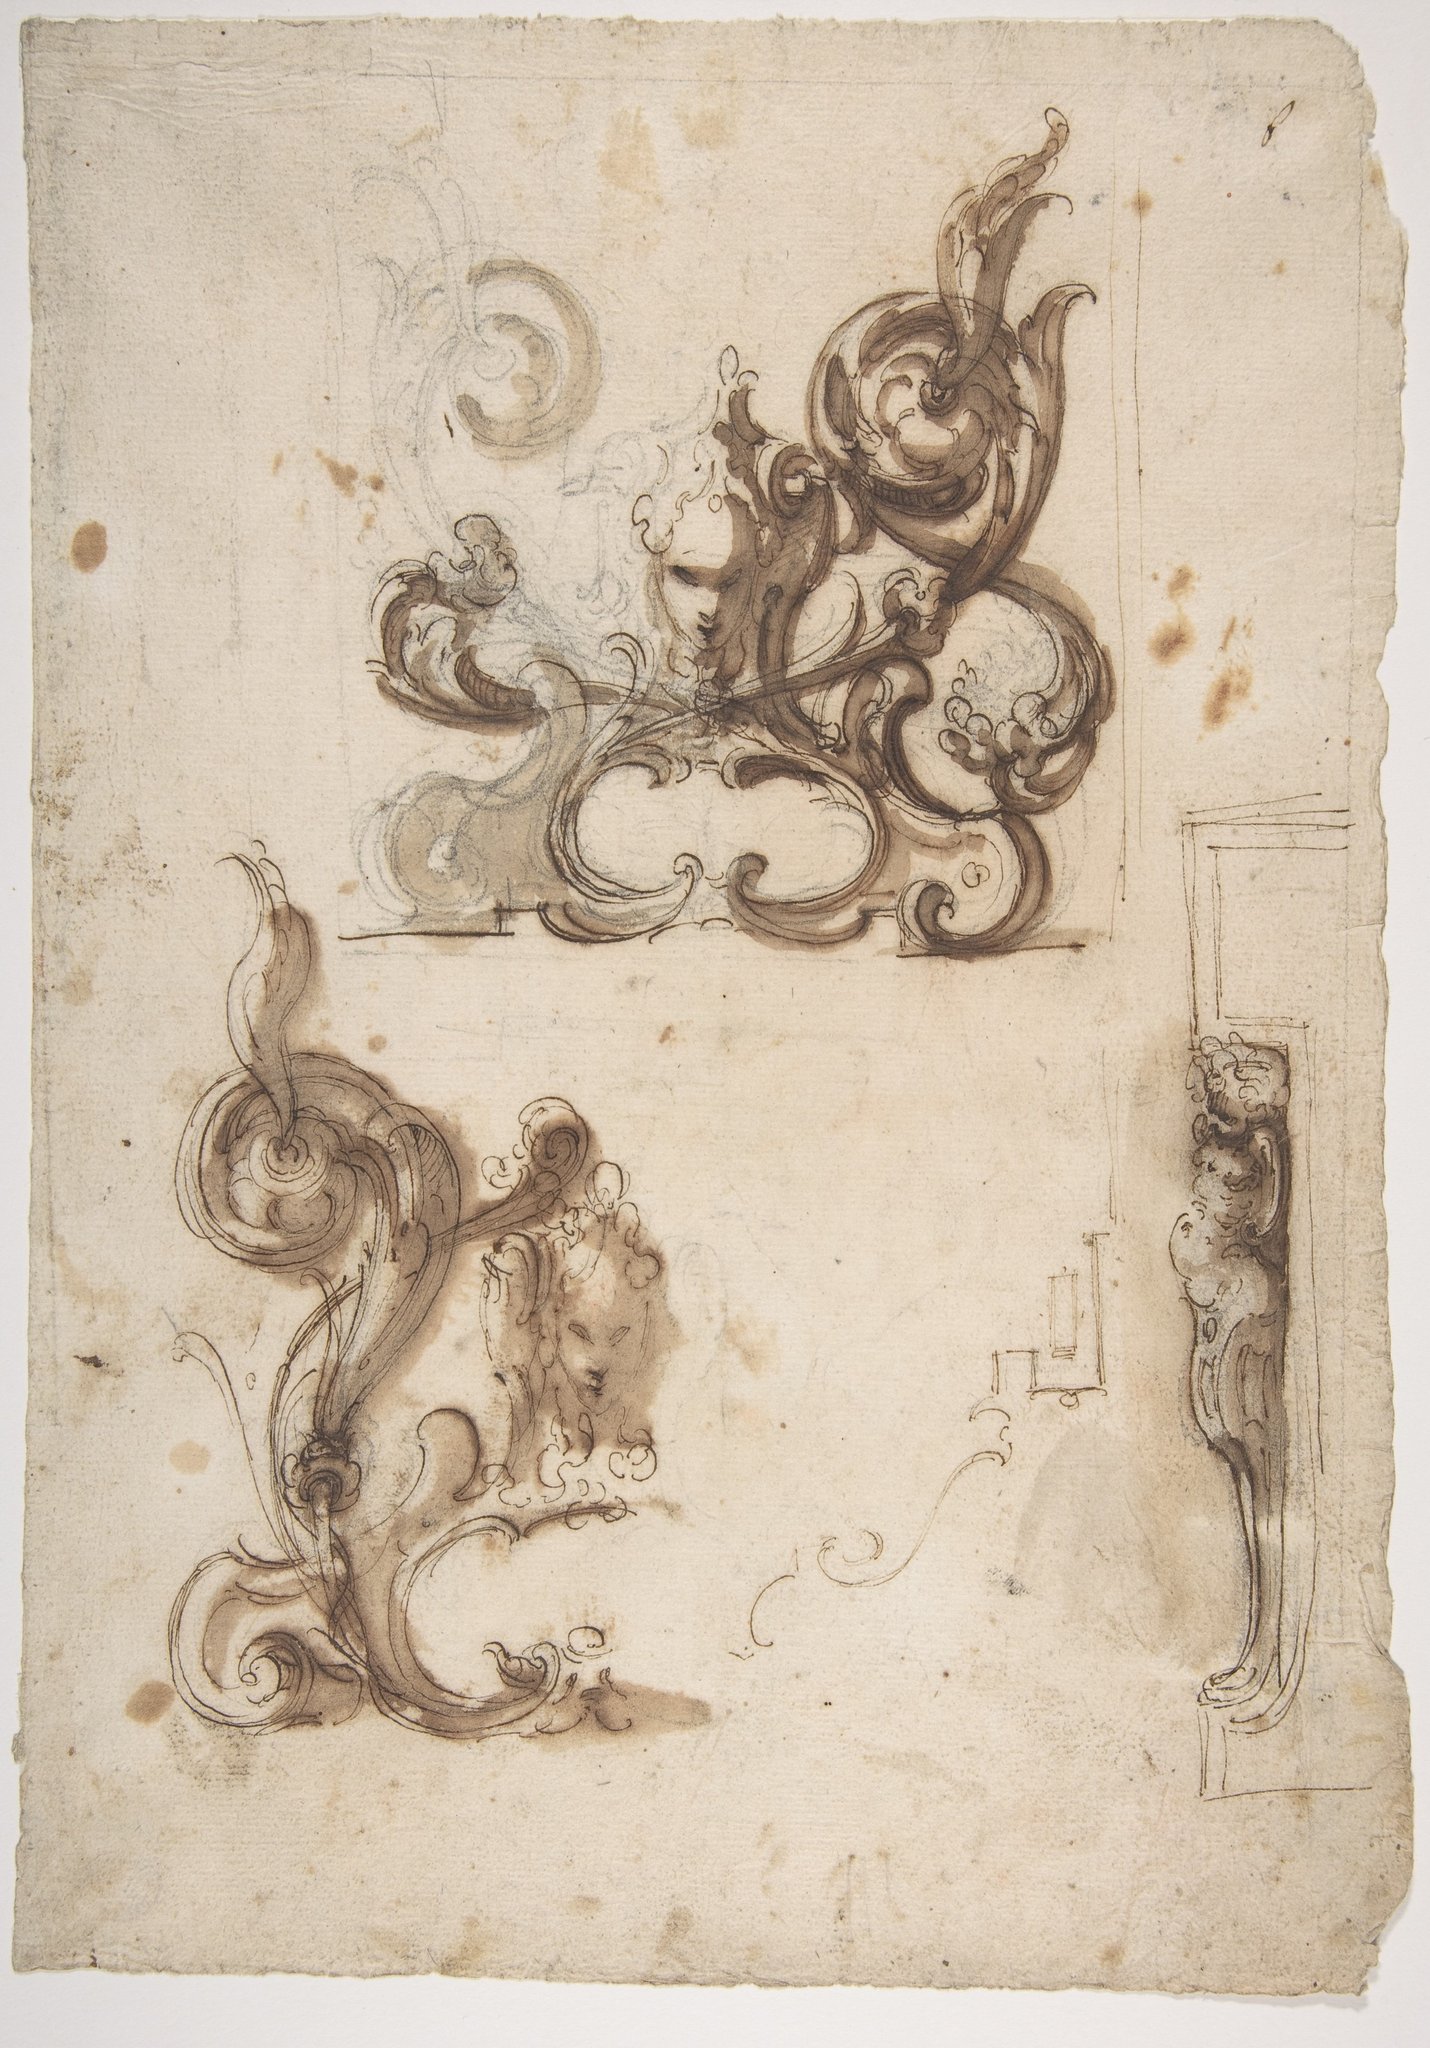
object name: drawing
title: Designs for Ornamental Motifs and for a Herm Supporting a Chimney Piece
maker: guglielmo caccia, called il moncalvo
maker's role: artist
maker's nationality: italian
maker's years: 1568-1625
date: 1568-1625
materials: chalk, ink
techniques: brush, pen, wash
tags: ornament